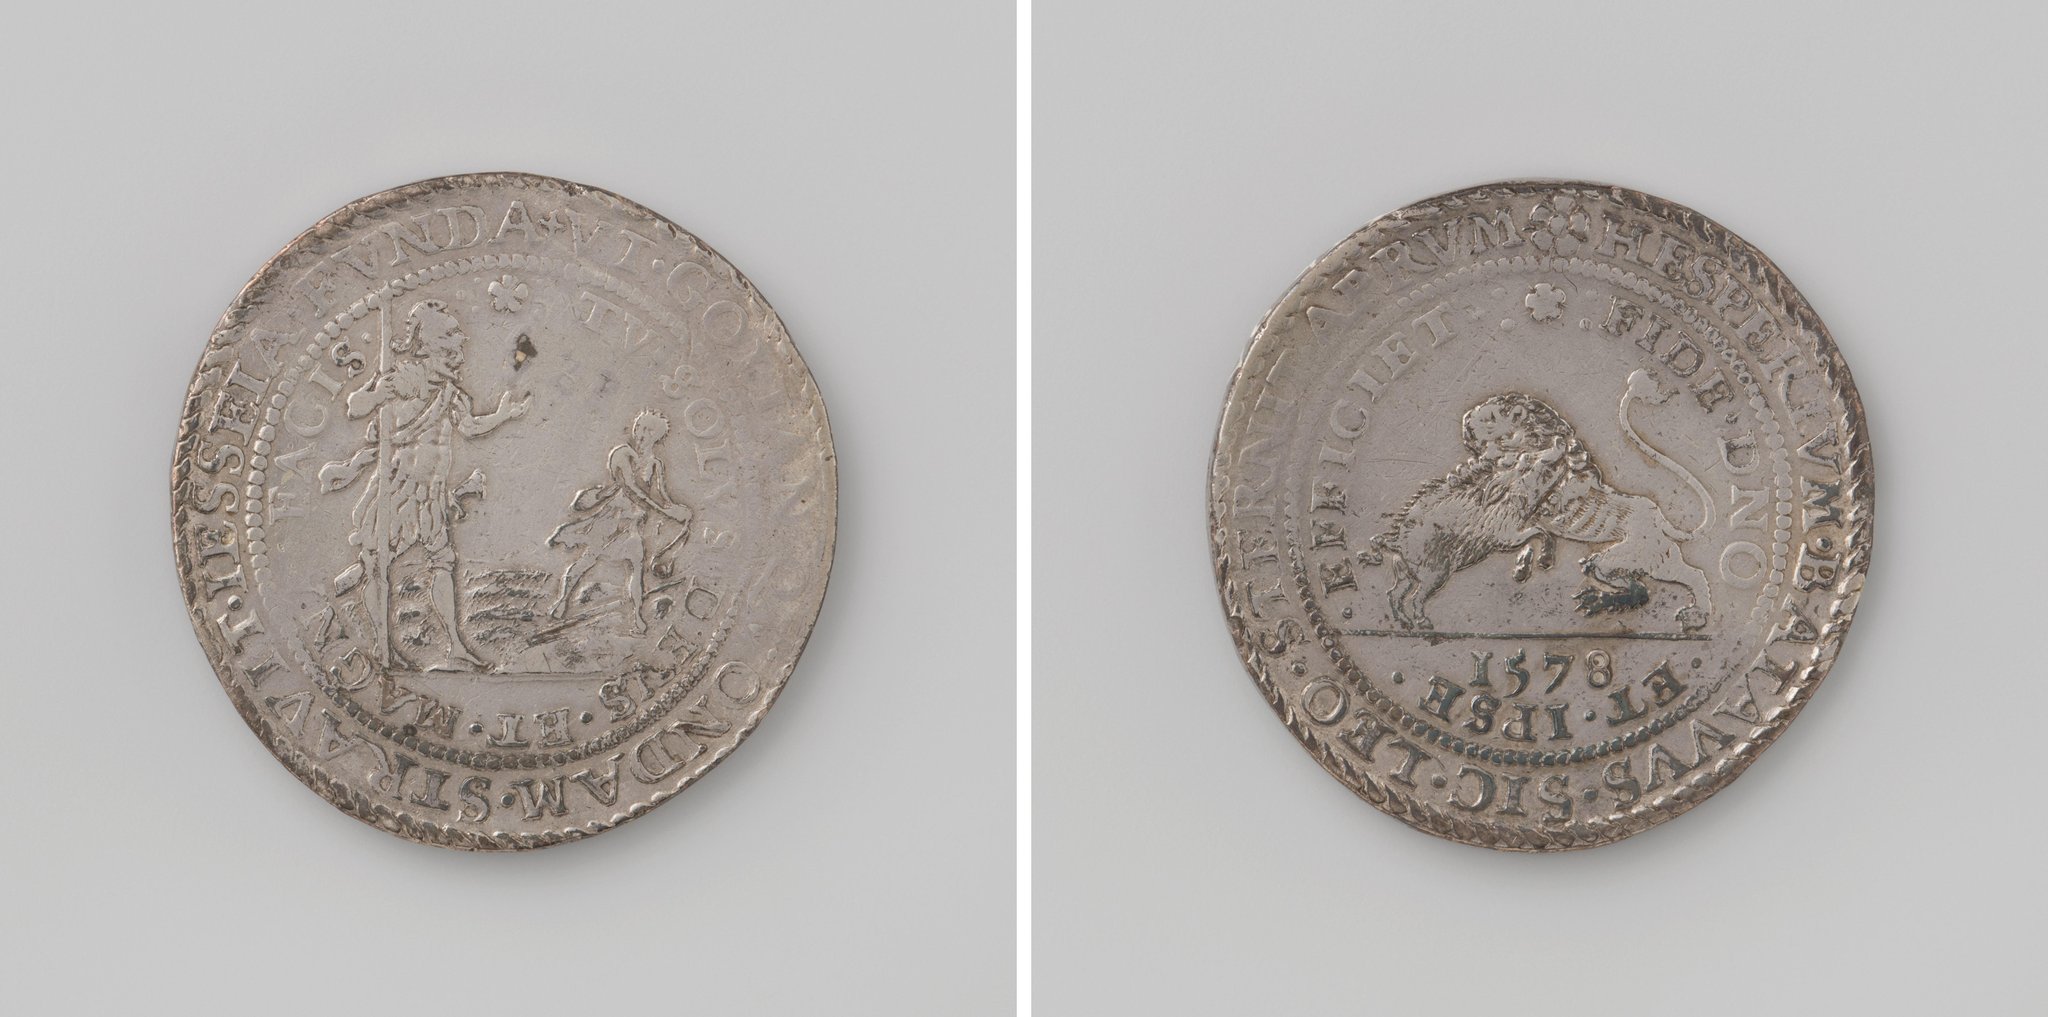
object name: triomfpenning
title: Succes in de strijd tegen Spanje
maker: gerard van bylaer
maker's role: die cutter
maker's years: 1540-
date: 1578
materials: silver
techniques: striking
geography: dordrecht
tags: tachtigjarige oorlog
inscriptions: circumscription, circumscription: ‘FIDE DNO ET IPSE EFFICIET’, circumscription: ‘VT GOLIATA SEVVM STRAVIT IESSEIA FVNDA’, circumscription: ‘TV SOVS DEVS ET MAGNA FACIS’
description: Zilveren penning. Voorzijde: Goliath met speer in volle wapenrusting en David met zijn slinger binnen tweeregelig omschrift. Keerzijde: Nederlandse leeuw bespringt Spaanse everzwijn boven jaartal binnen tweeregelig omschrift.